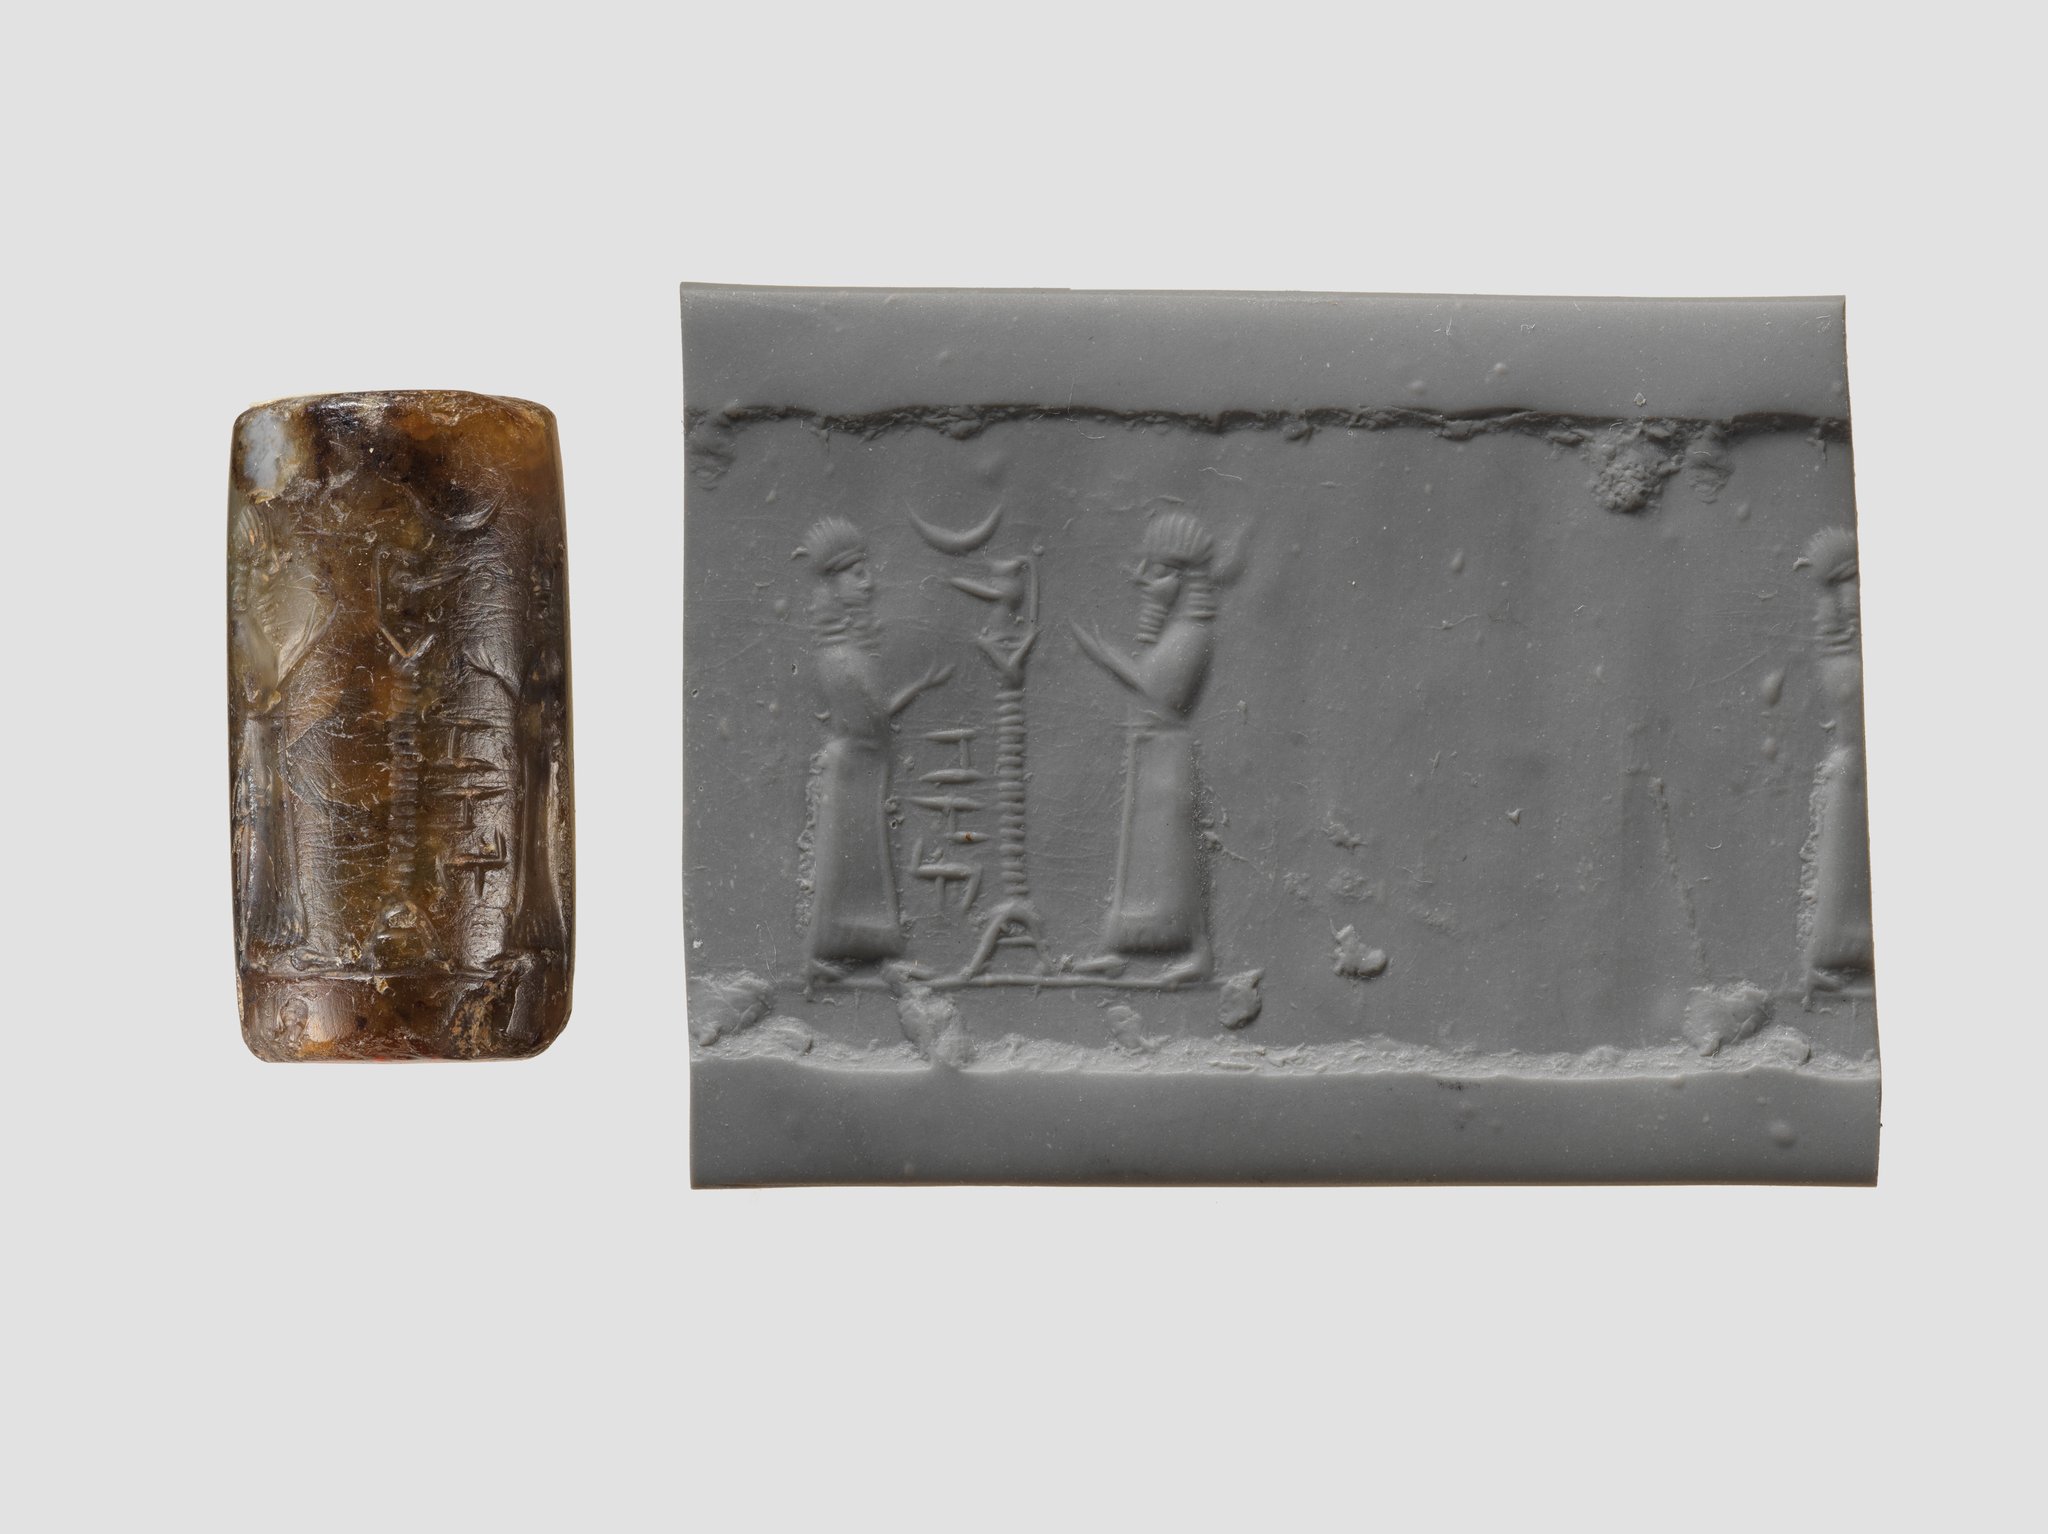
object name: cylinder seal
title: Cylinder seal with cultic scene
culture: assyro-babylonian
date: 800-601 BCE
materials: stone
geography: mesopotamia